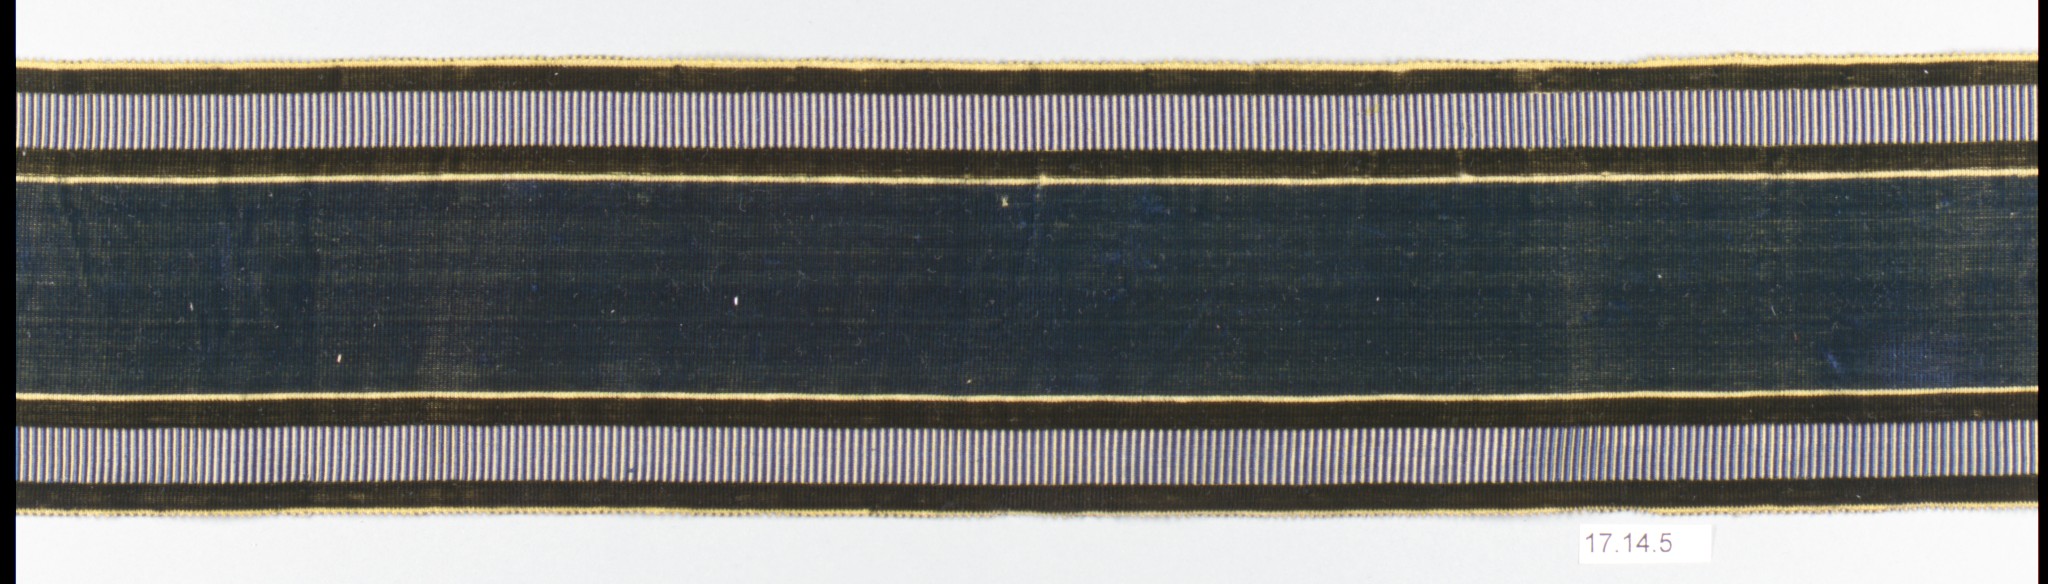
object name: ribbon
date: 1701-1800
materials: velvet